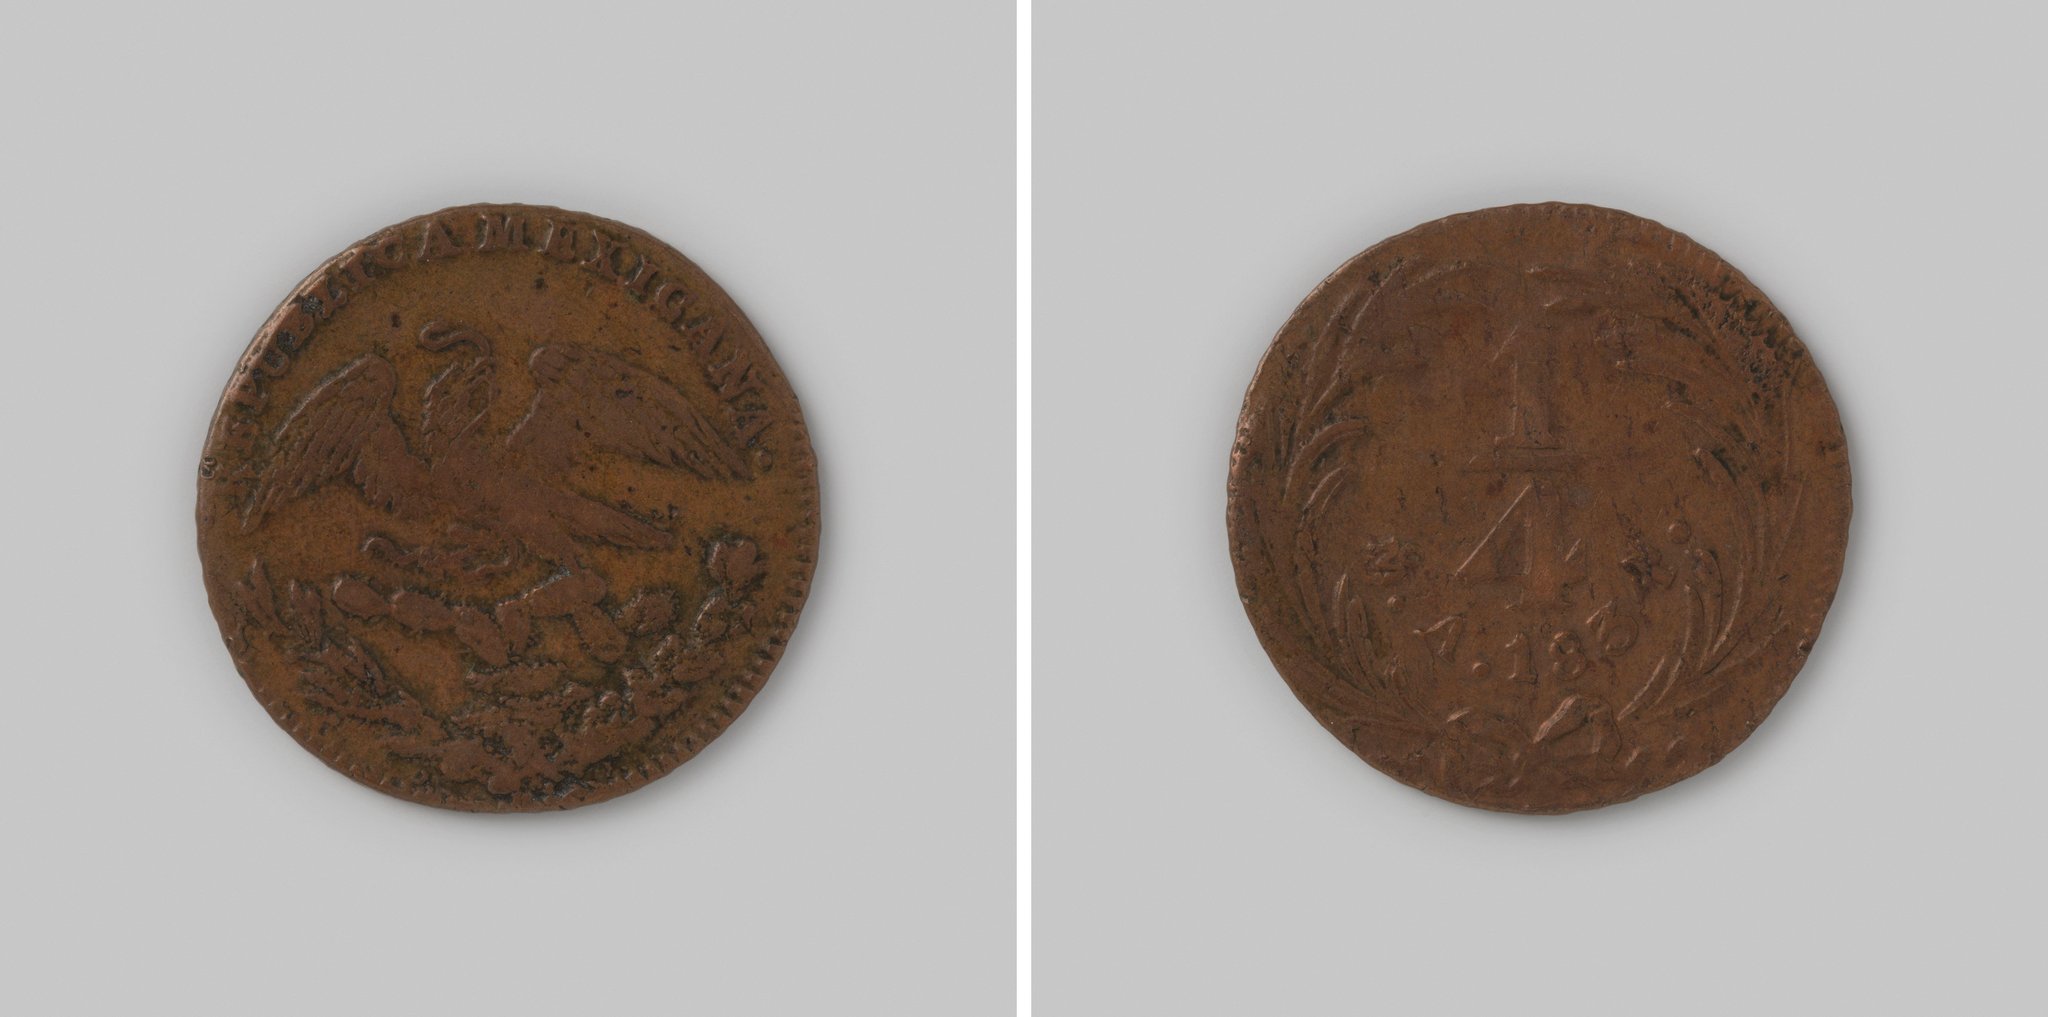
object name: cuartilla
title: Mexico, cuartilla of 1/4 reaal, 1836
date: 1836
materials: copper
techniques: striking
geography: mexico city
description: Koperen munt. Voorzijde: tussen twee samengebonden takken op cactusplant staande adelaar met gespreide vleugels met zijn kop naar rechts met in zijn bek een slang. Keerzijde: tussen twee samengebonden takken waarde-aanduiding: 1/4, waaronder muntplaats-aanduiding: Mo. en jaartal. Kartelrand.